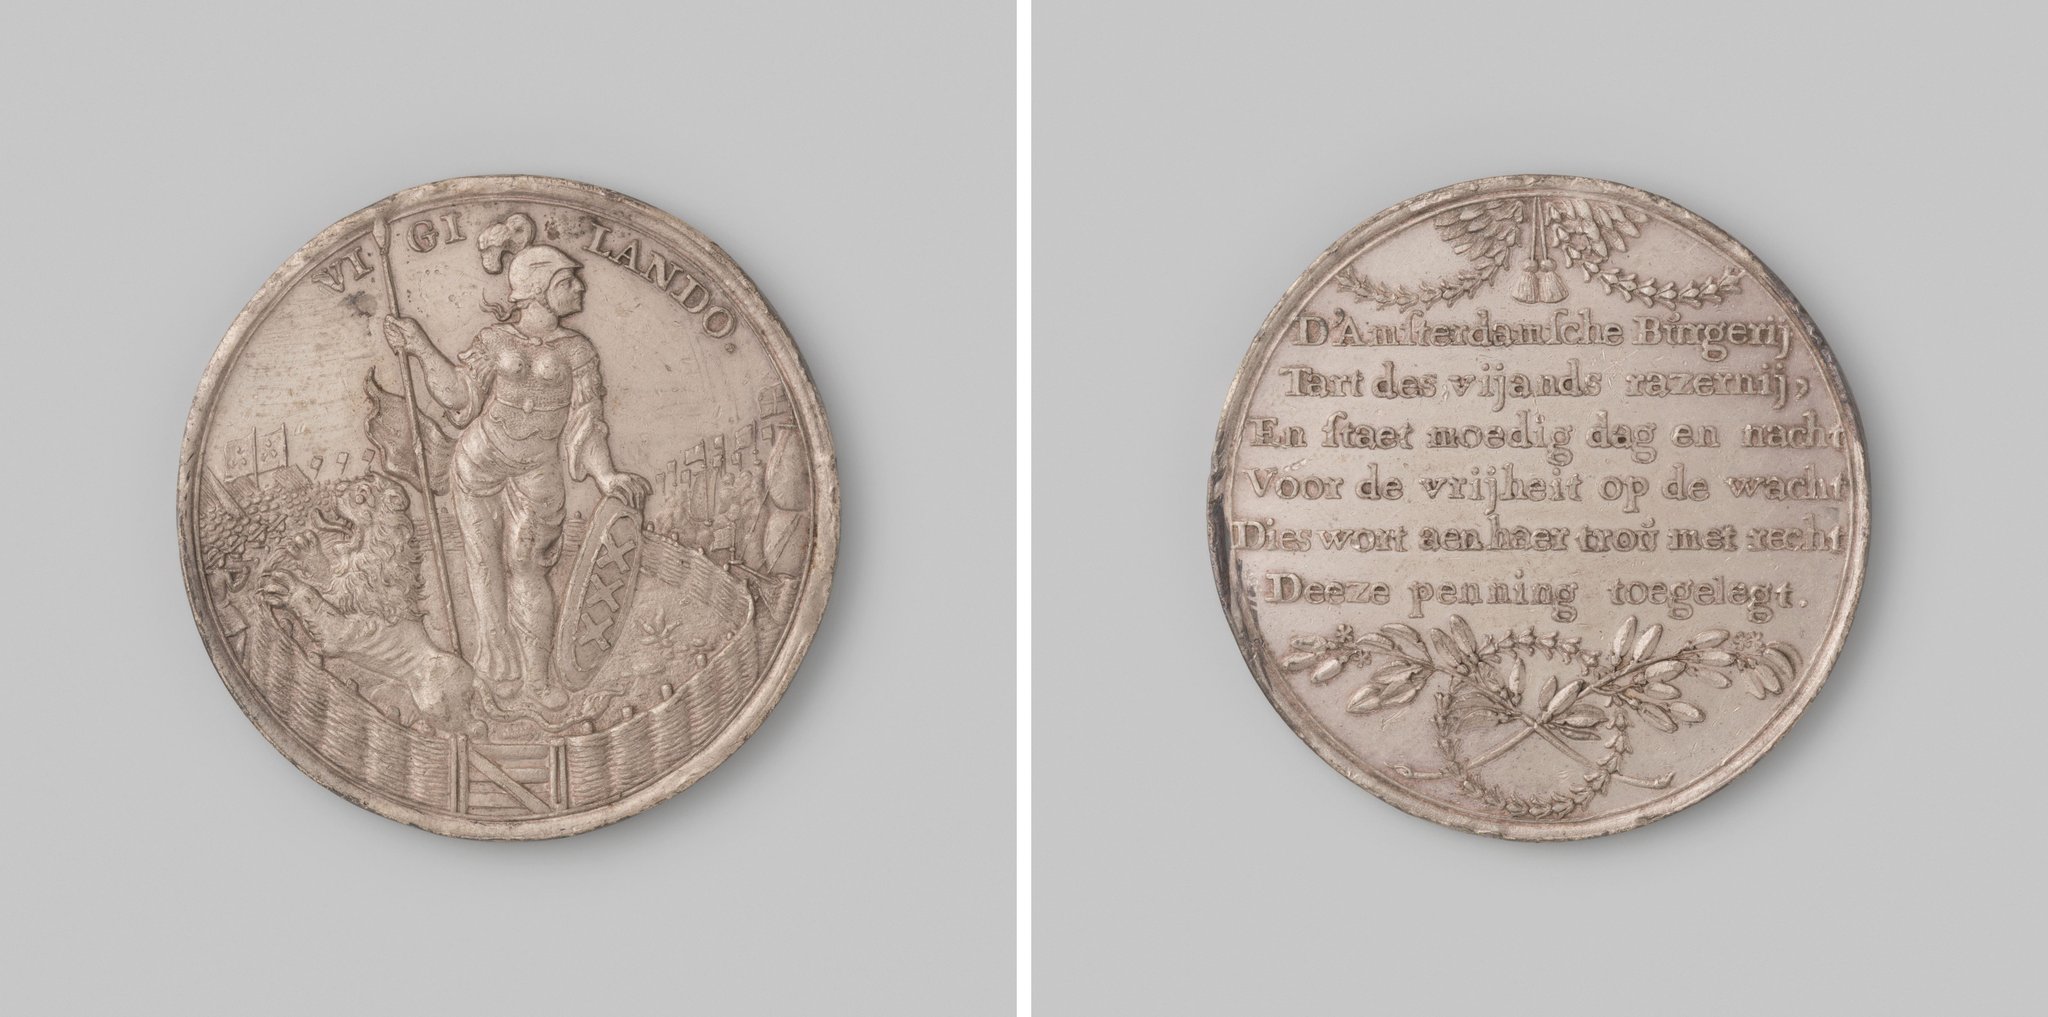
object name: history medal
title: Gedenkpenning te Amsterdam, door de magistraat aan de schutters uitgereikt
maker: Anonymous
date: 1672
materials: silver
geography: amsterdam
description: Zilveren gedenkpenning. Voorzijde: de Amsterdamse Stedemaagd met helm, gewapend met speer en schild en met de Nederlandse leeuw binnen de goed gesloten Hollandse tuin, het vijandelijke leger en de vloot in het gezicht. Omschrift: VIGILANDE (Voor het waken). Keerzijde: d' Amsterdamsche burgerij/ Tart des vijands razernij,/ En staet moedig dag en nacht/ Voor de Vrijheit op de wacht,/ Dies wort aen haer troû met recht/ Deeze penning toegelegt. Hieronder een lauwerkrans met twee zegetakken.